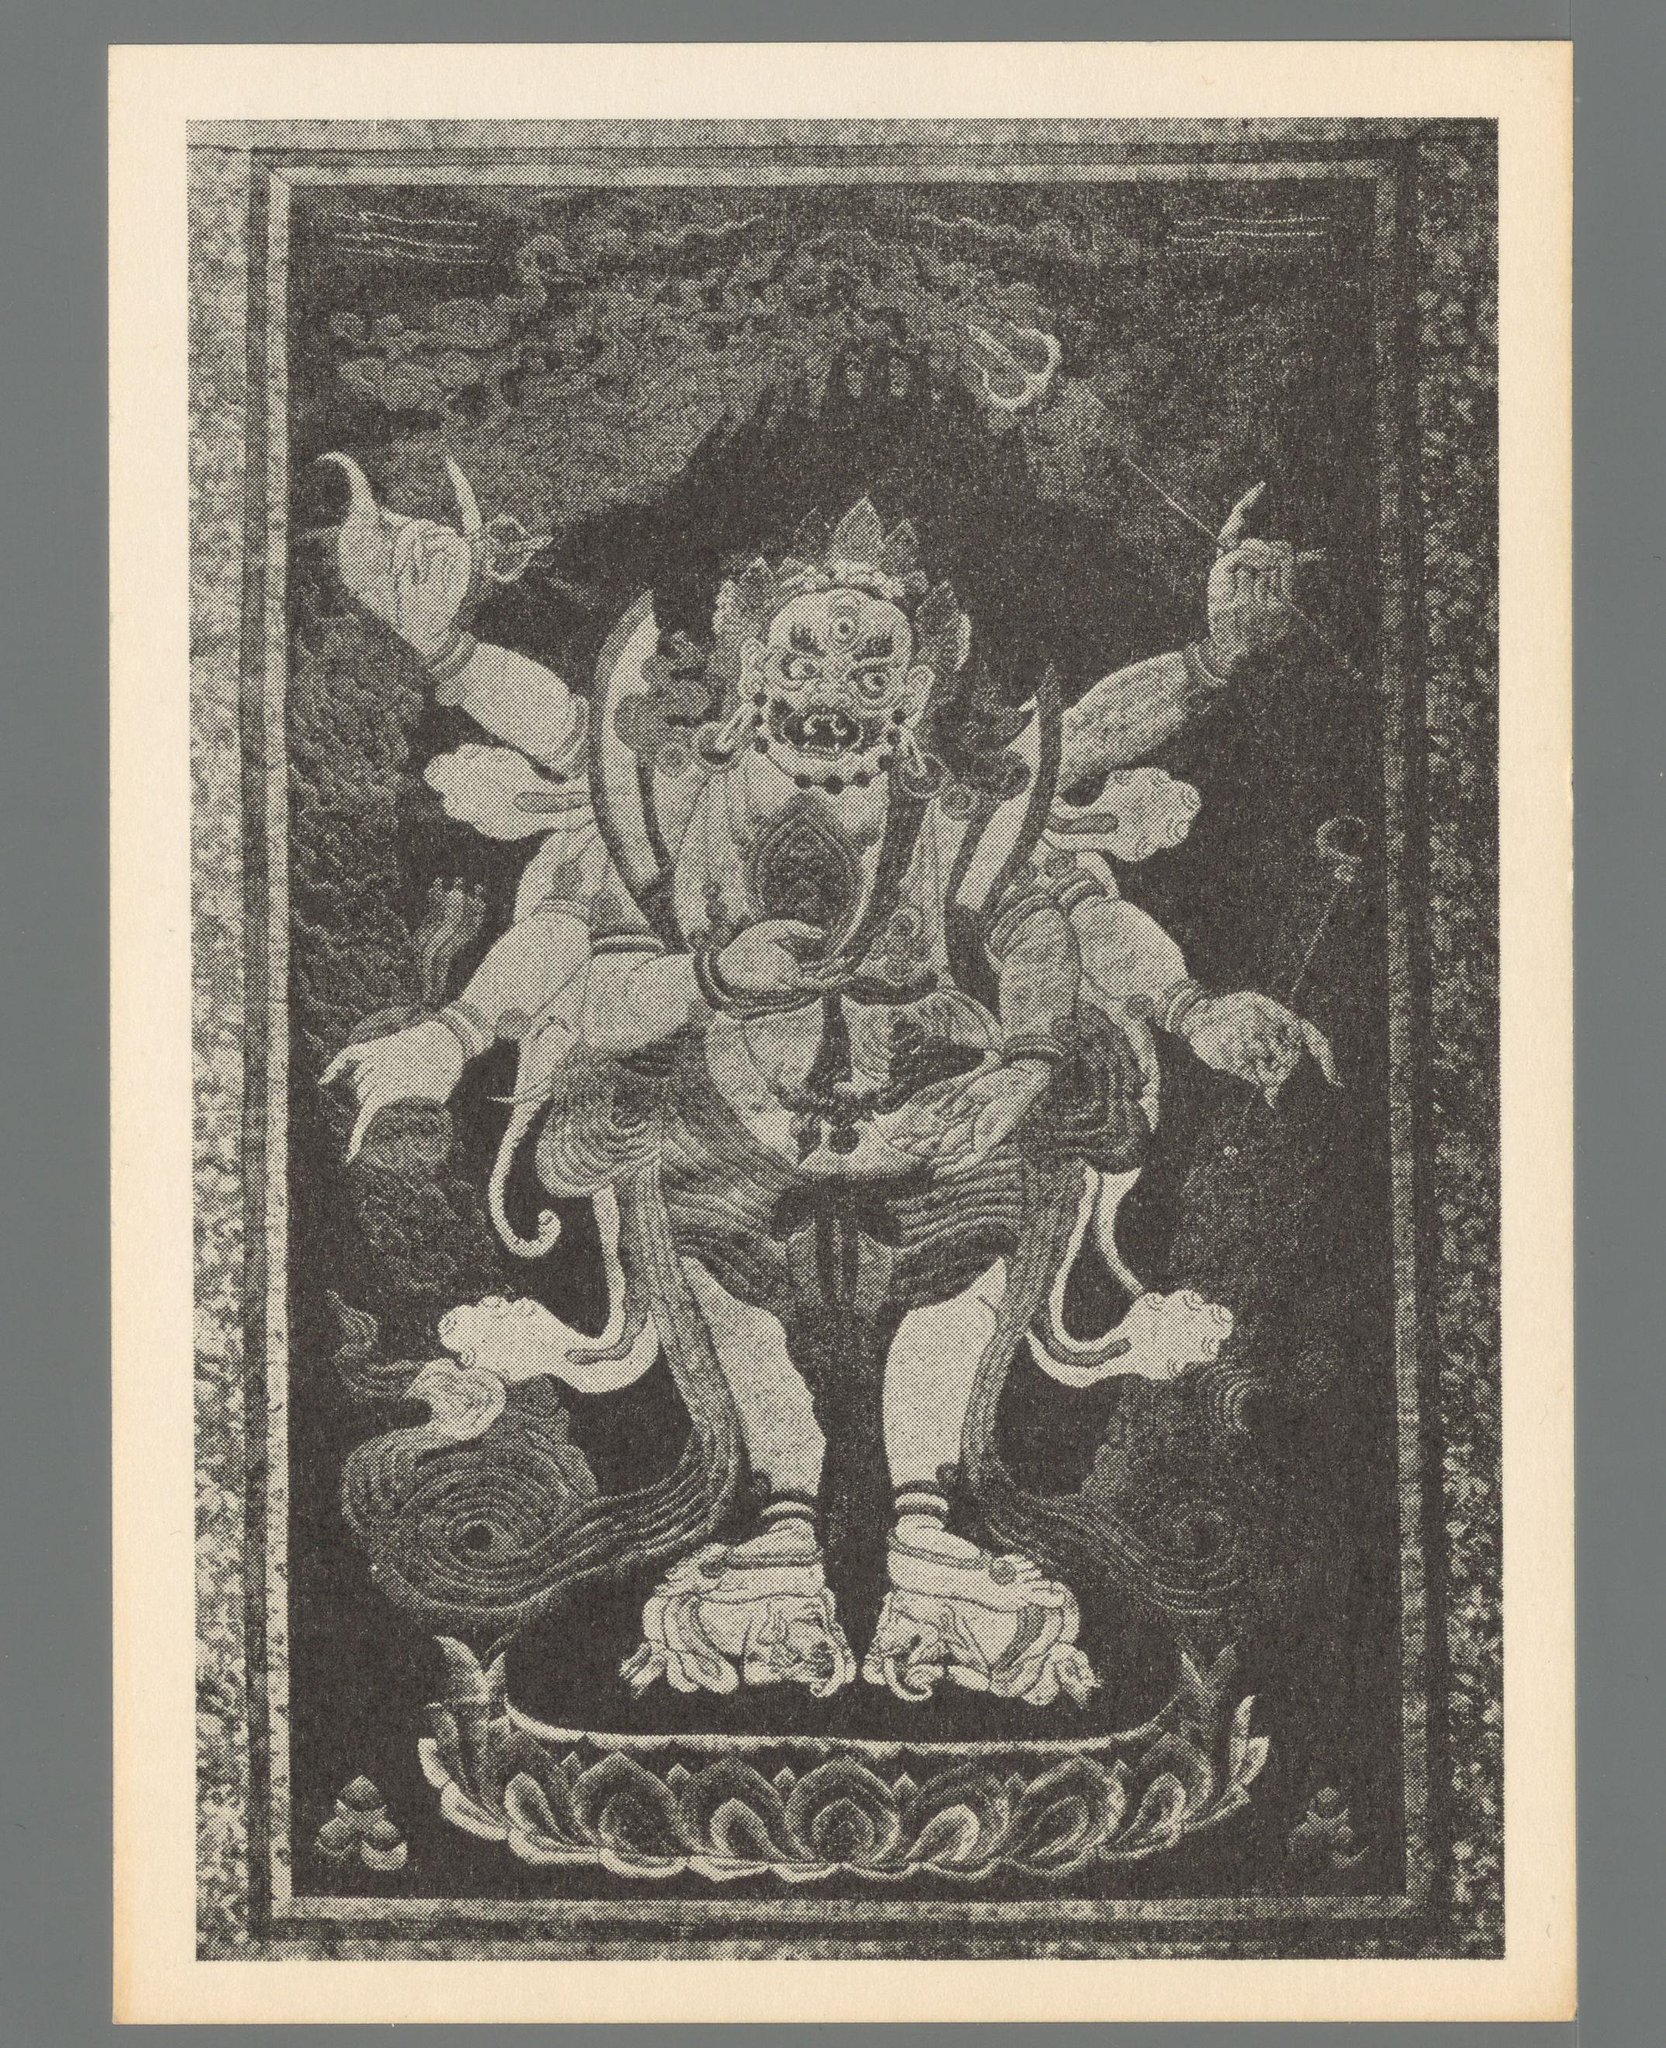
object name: ansichtkaart, prentbriefkaart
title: Guden Mahakala. Tempelbroderi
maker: Anonymous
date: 1952-1979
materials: cardboard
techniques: autotype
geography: stockholm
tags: tapestry, representations ~ gods, demi-gods, heroes, etc. (hinduism, buddhism, jainism)